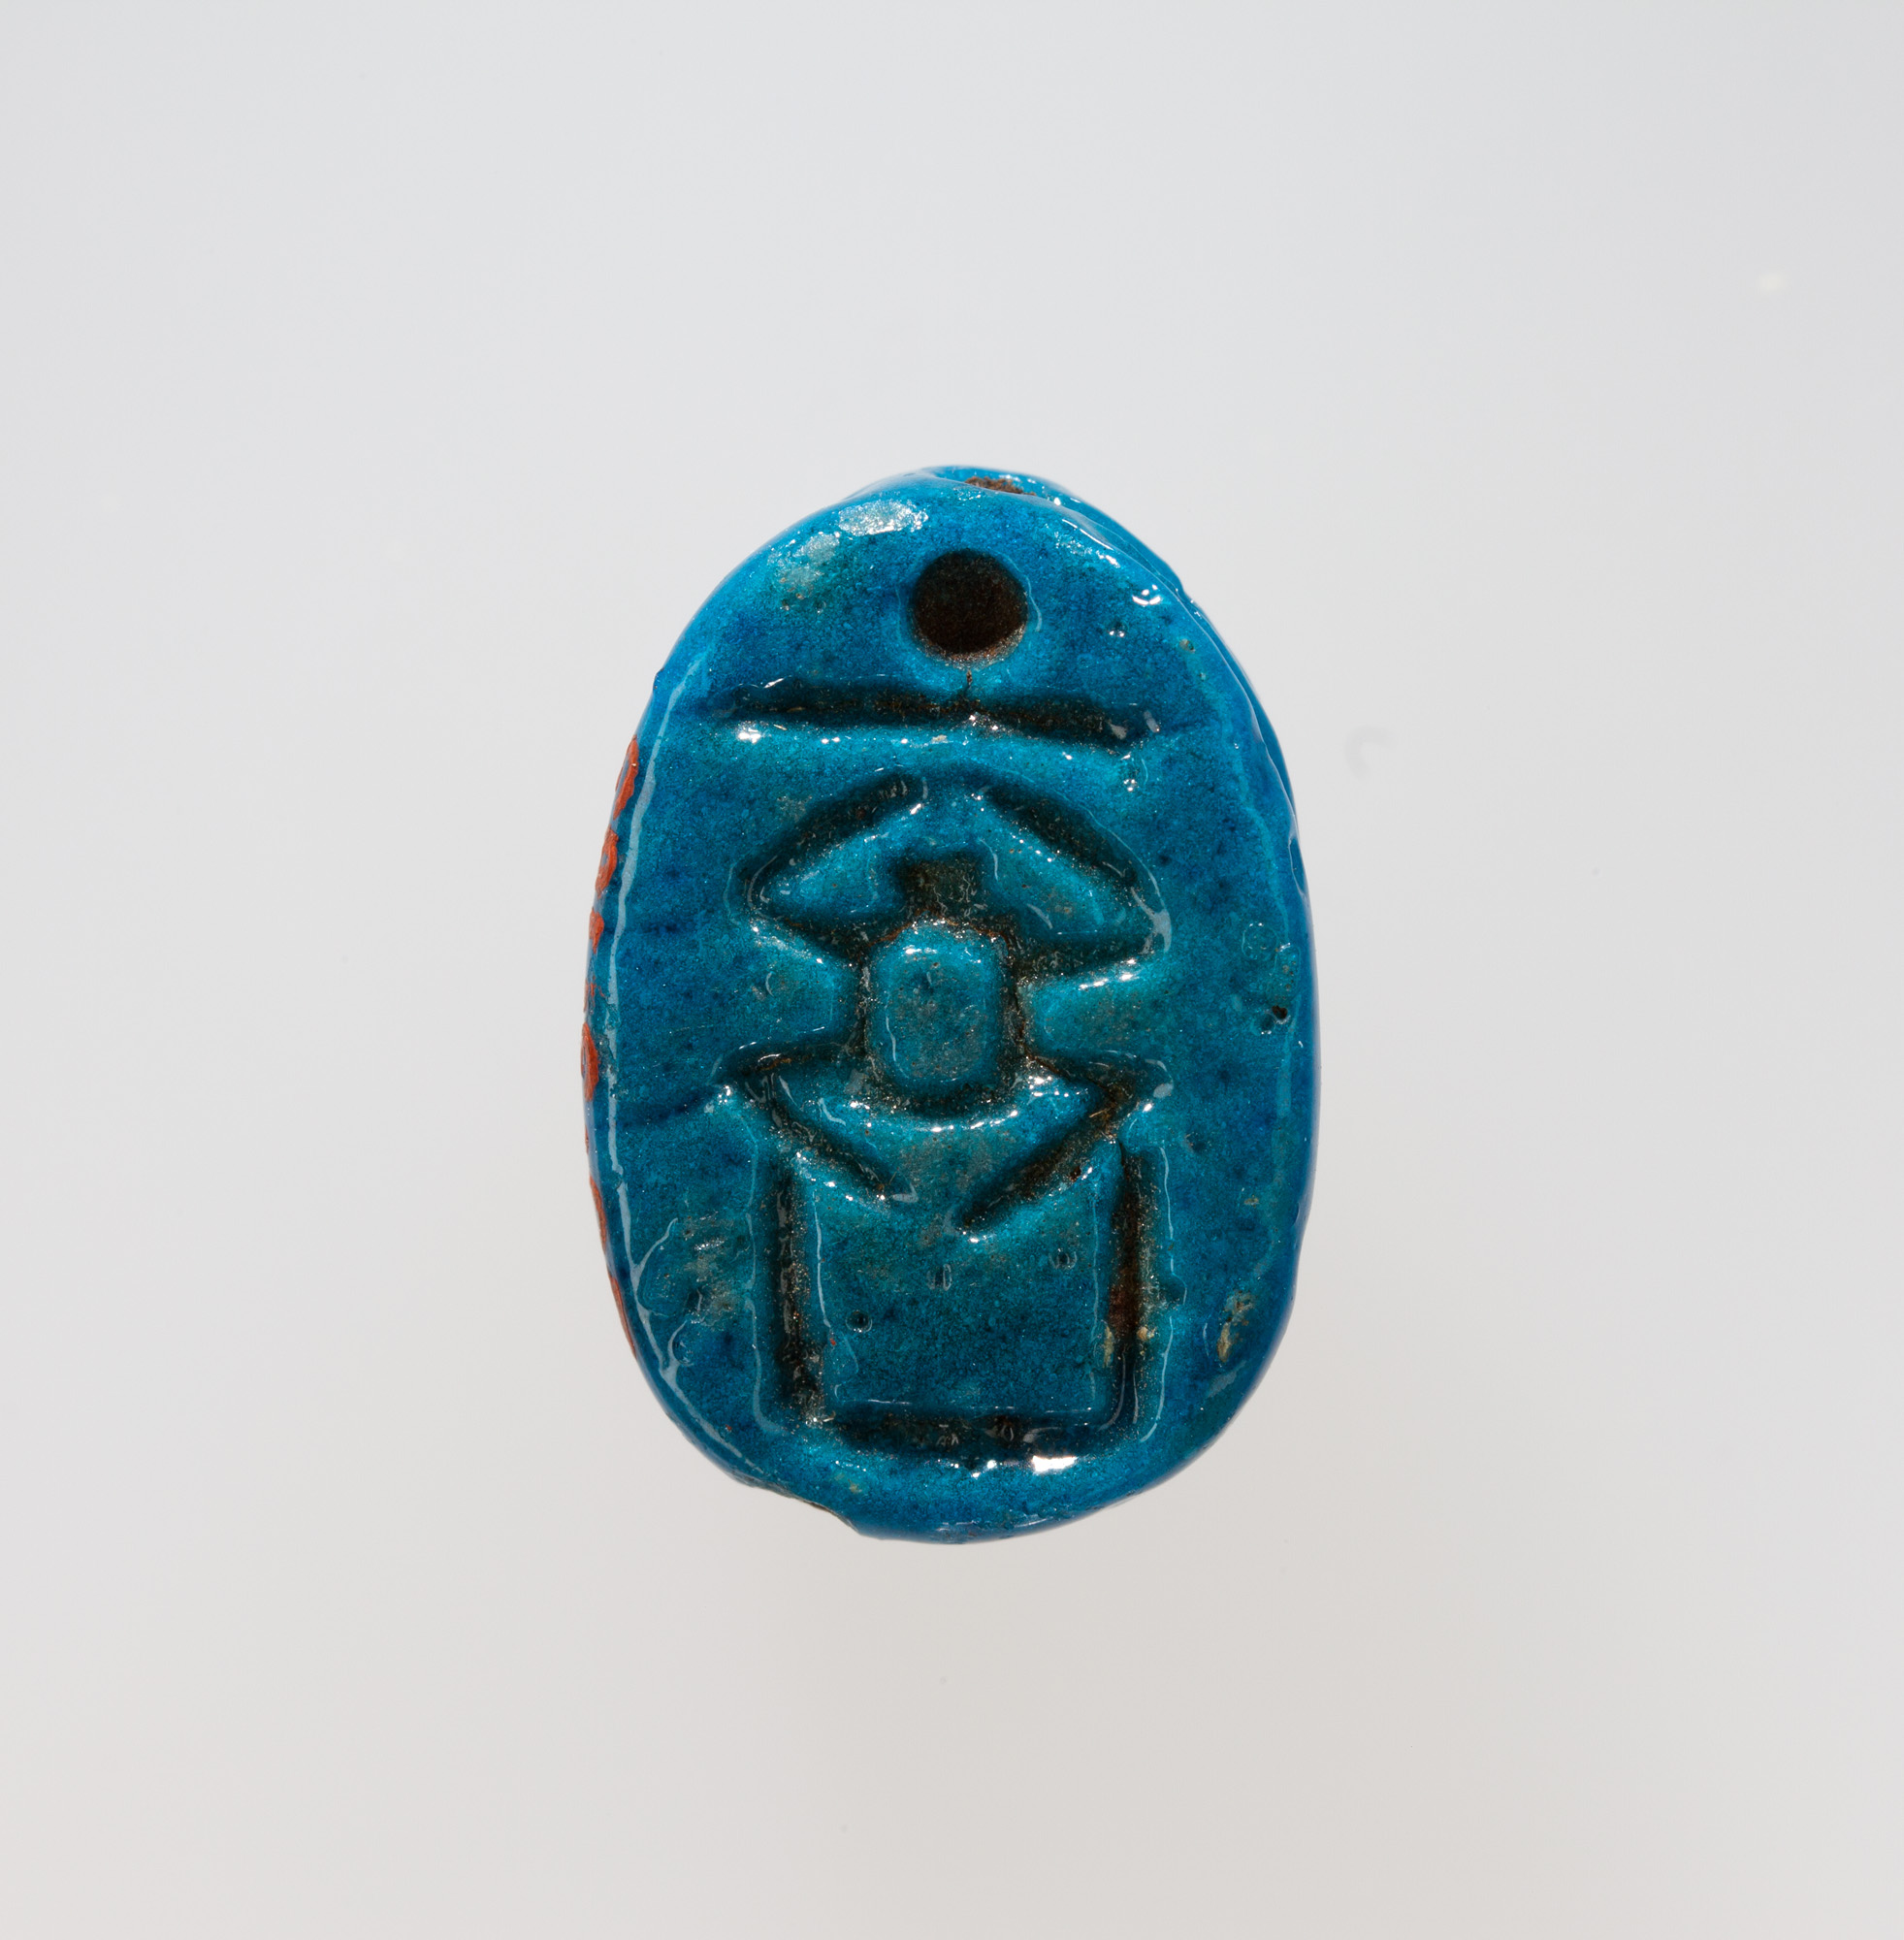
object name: scarab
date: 1479-1458 BCE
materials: faience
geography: egypt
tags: scarabs